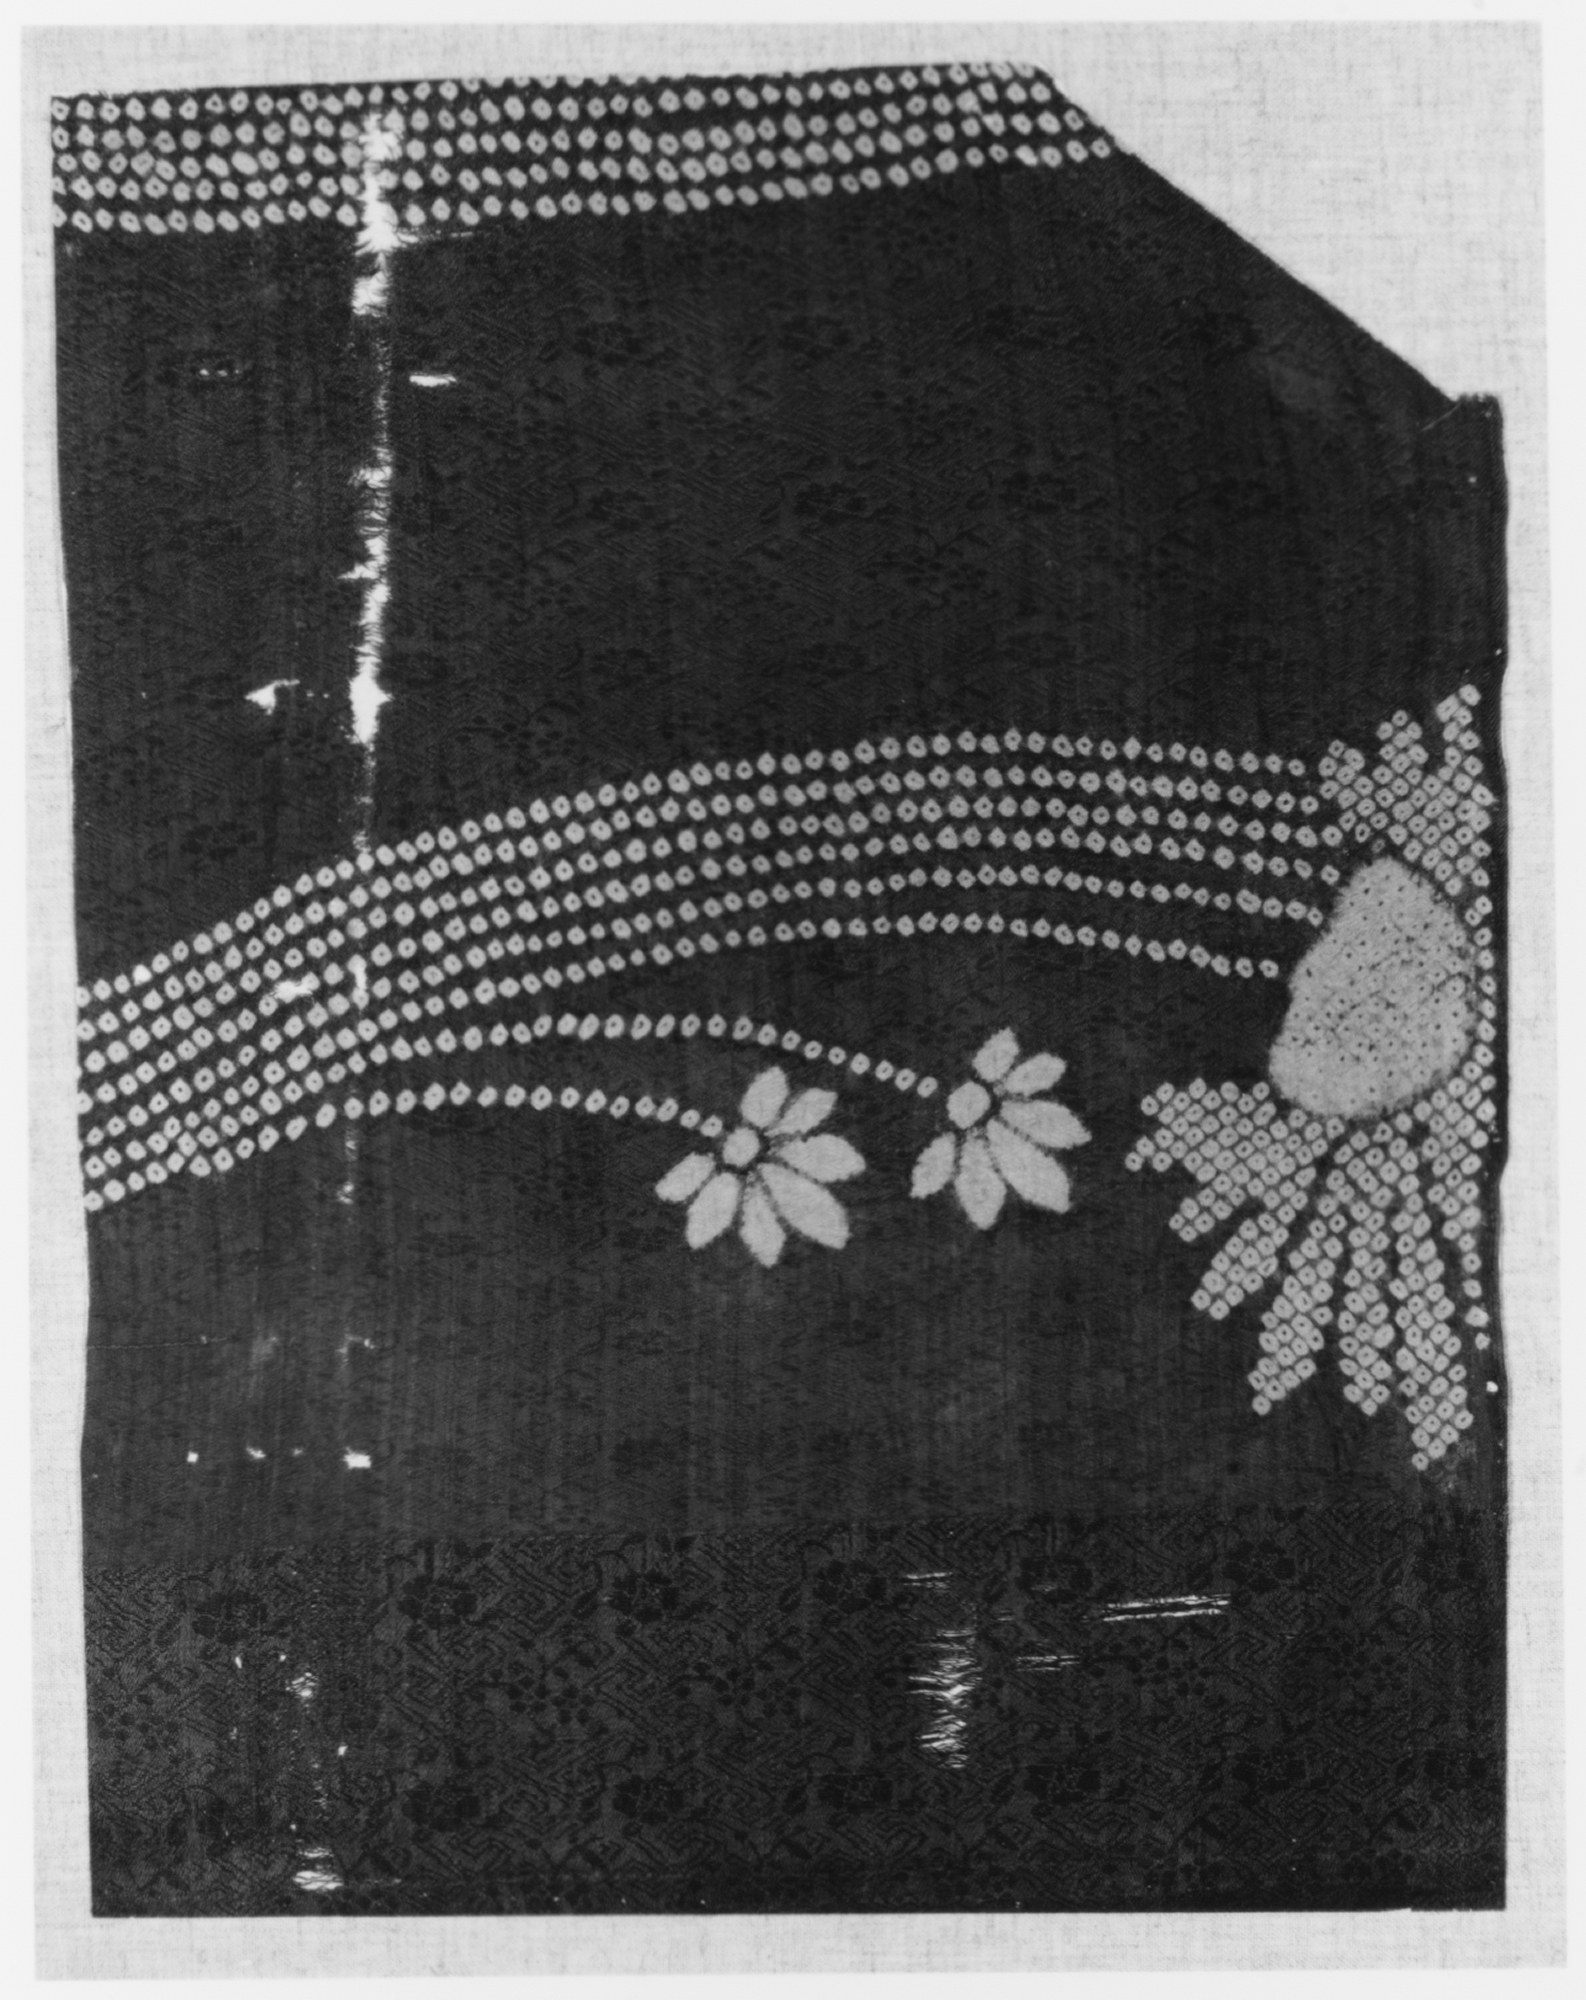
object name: piece from a kosode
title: Two Kosode Fragments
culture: japanese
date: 1651-1700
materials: textile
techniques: damask